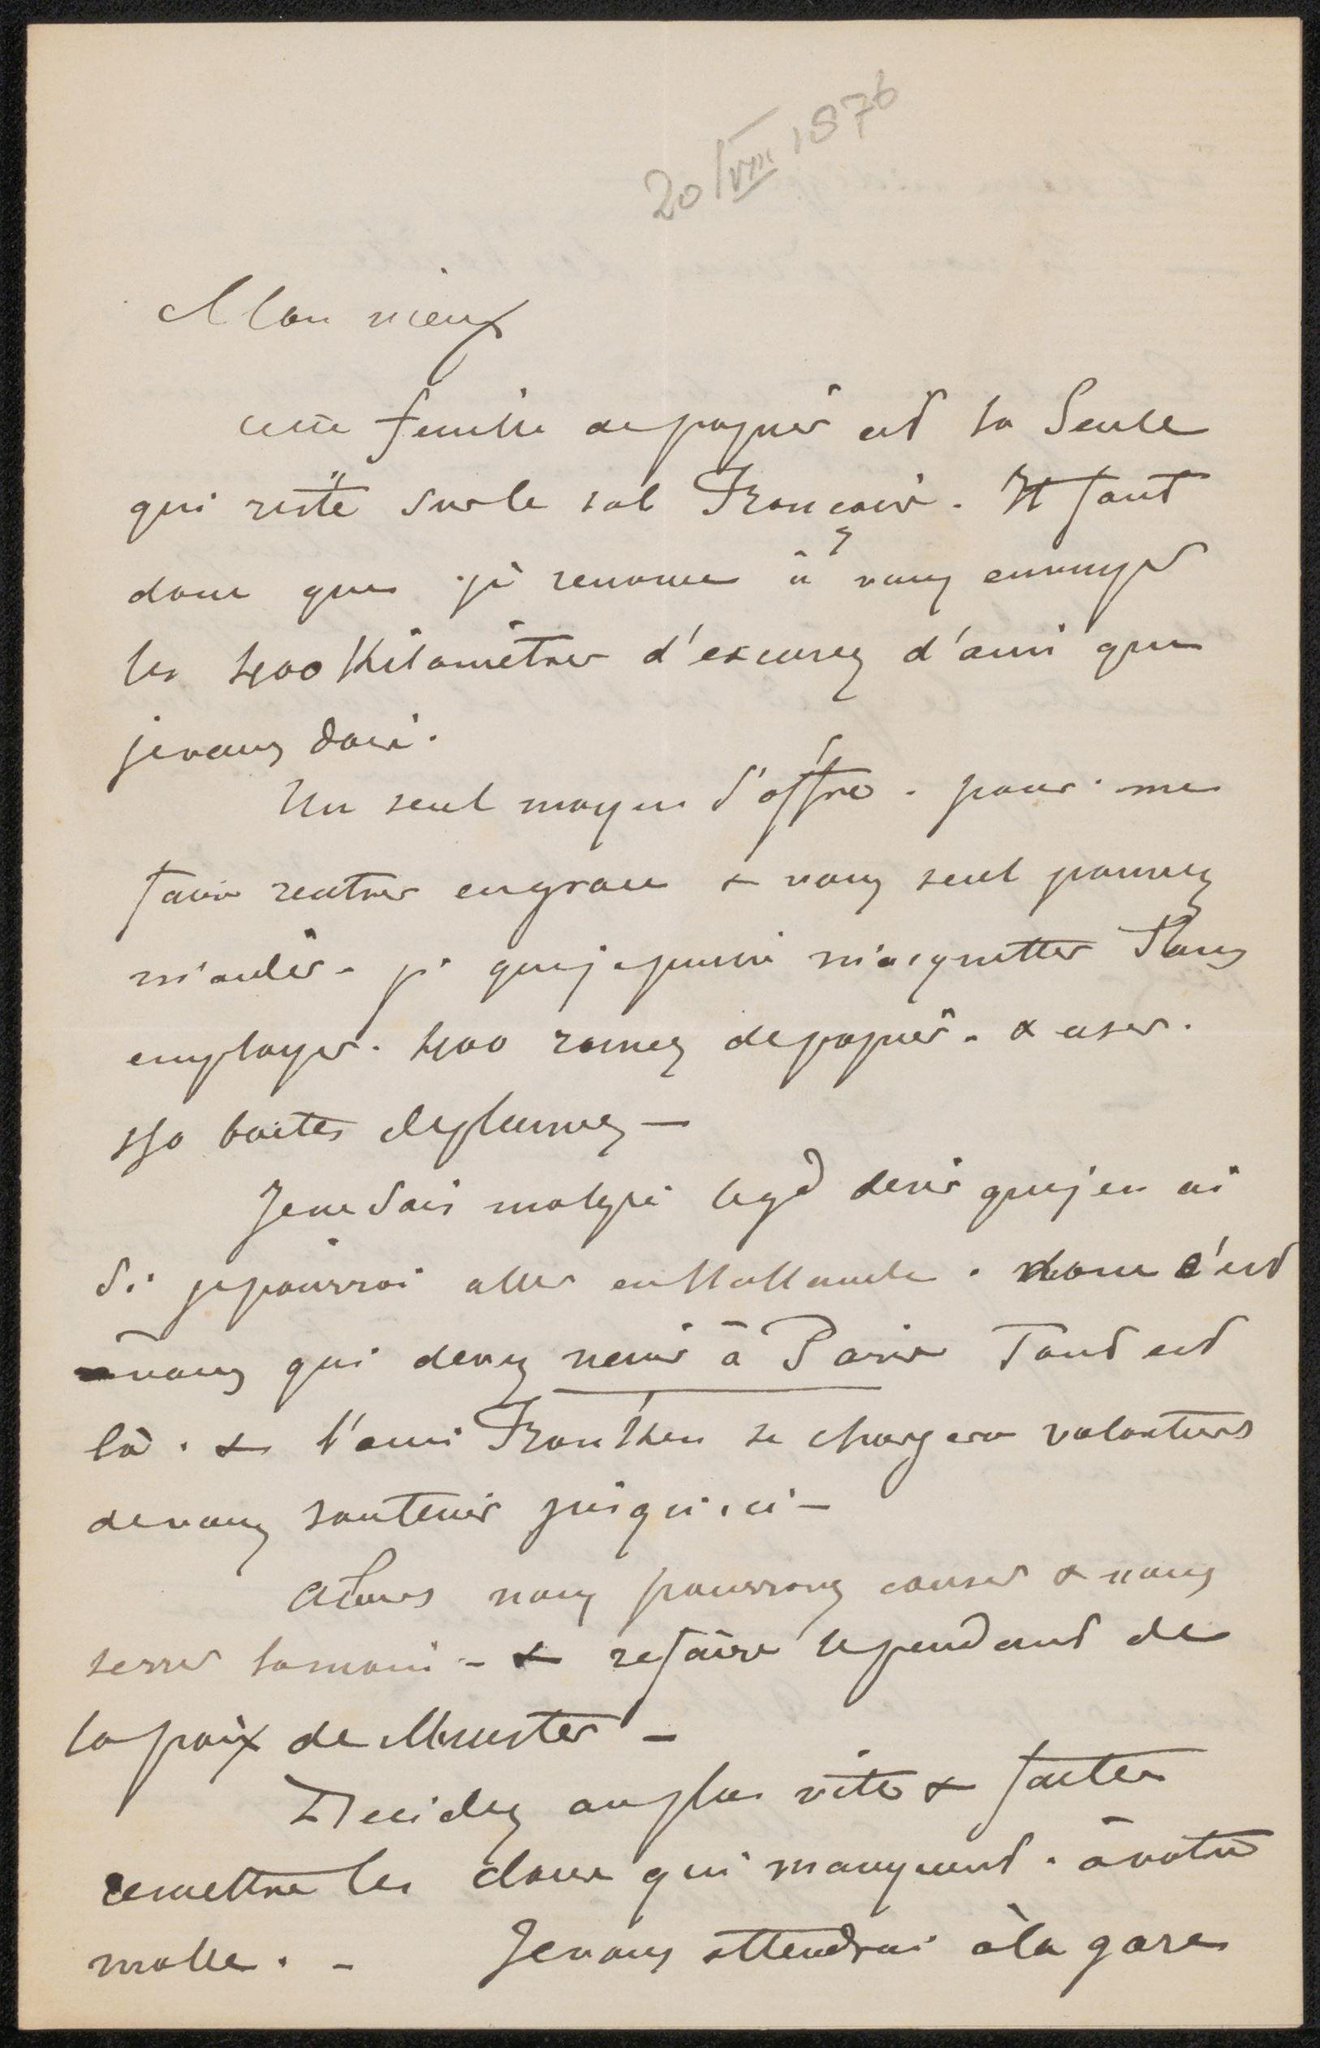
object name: letter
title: Brief aan Jan Hendrik Maschaupt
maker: adolphe mouilleron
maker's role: draughtsman, print maker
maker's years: 1820-1881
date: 1876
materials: ink, paper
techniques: pen, writing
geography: paris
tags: august allebé, painter, jan hendrik maschaupt, daniël franken dzn.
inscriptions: collector's mark: ‘RPK’